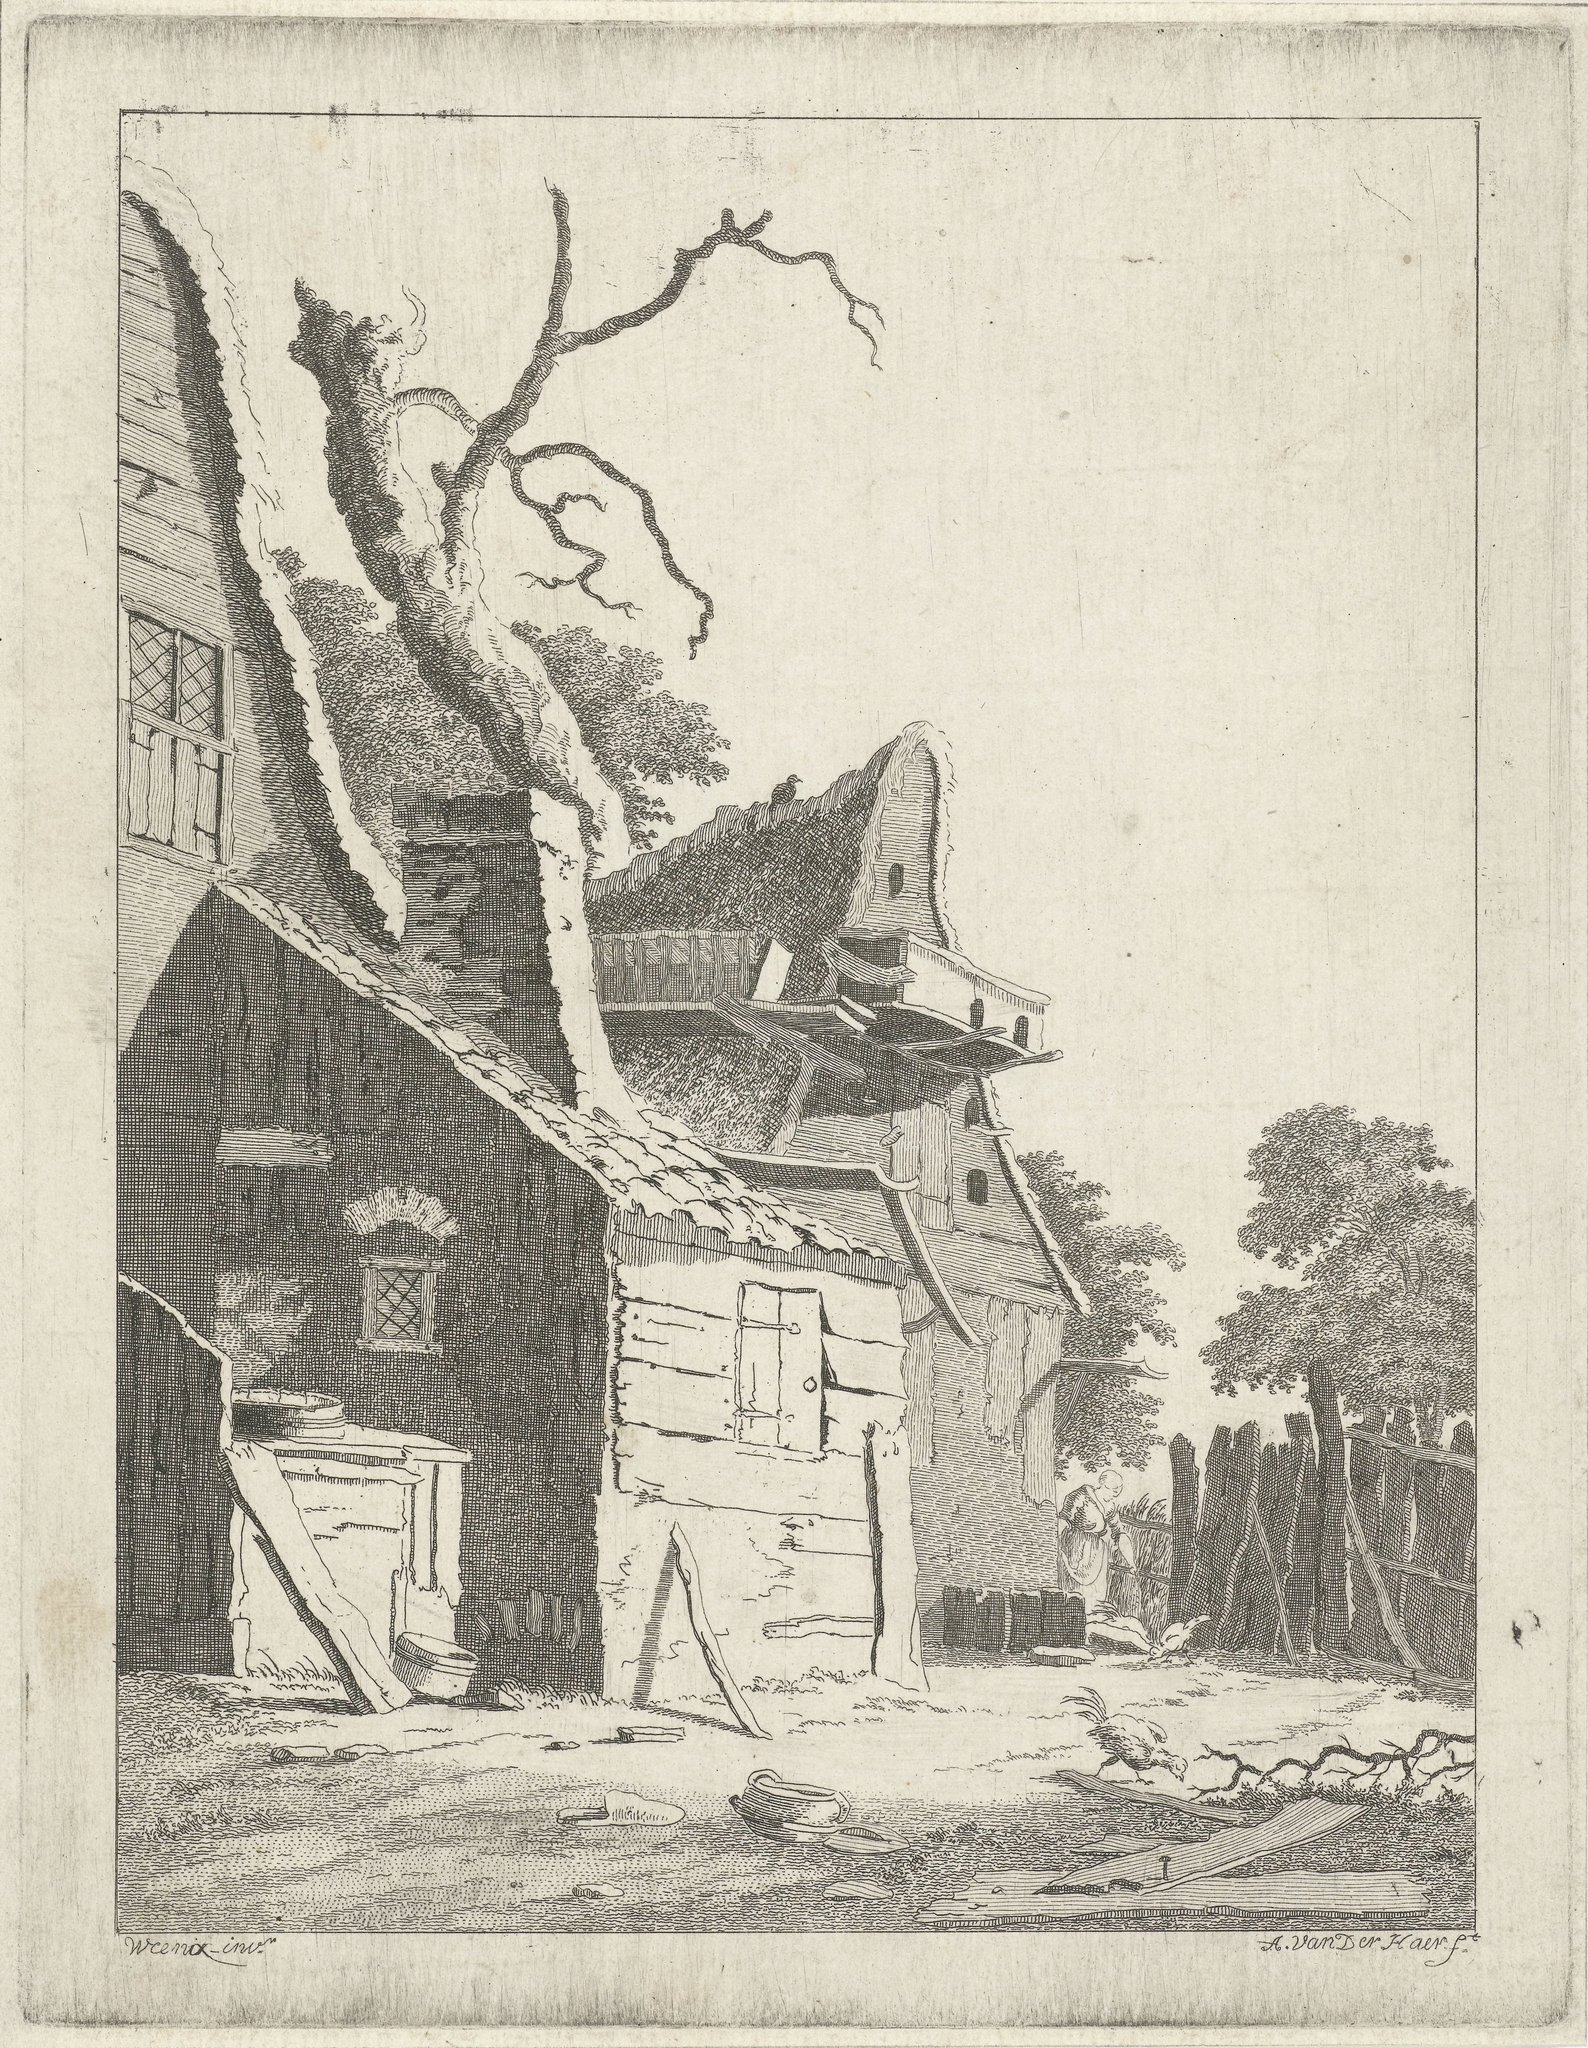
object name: print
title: Boerin bij een boerenwoning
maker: anthonij van der haer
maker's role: print maker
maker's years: 1730-1785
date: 1745-1785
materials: paper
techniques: etching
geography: northern netherlands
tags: farm or solitary house in landscape (+ city(-scape) with figures, staffage)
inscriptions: collector's mark: Lugt 2228